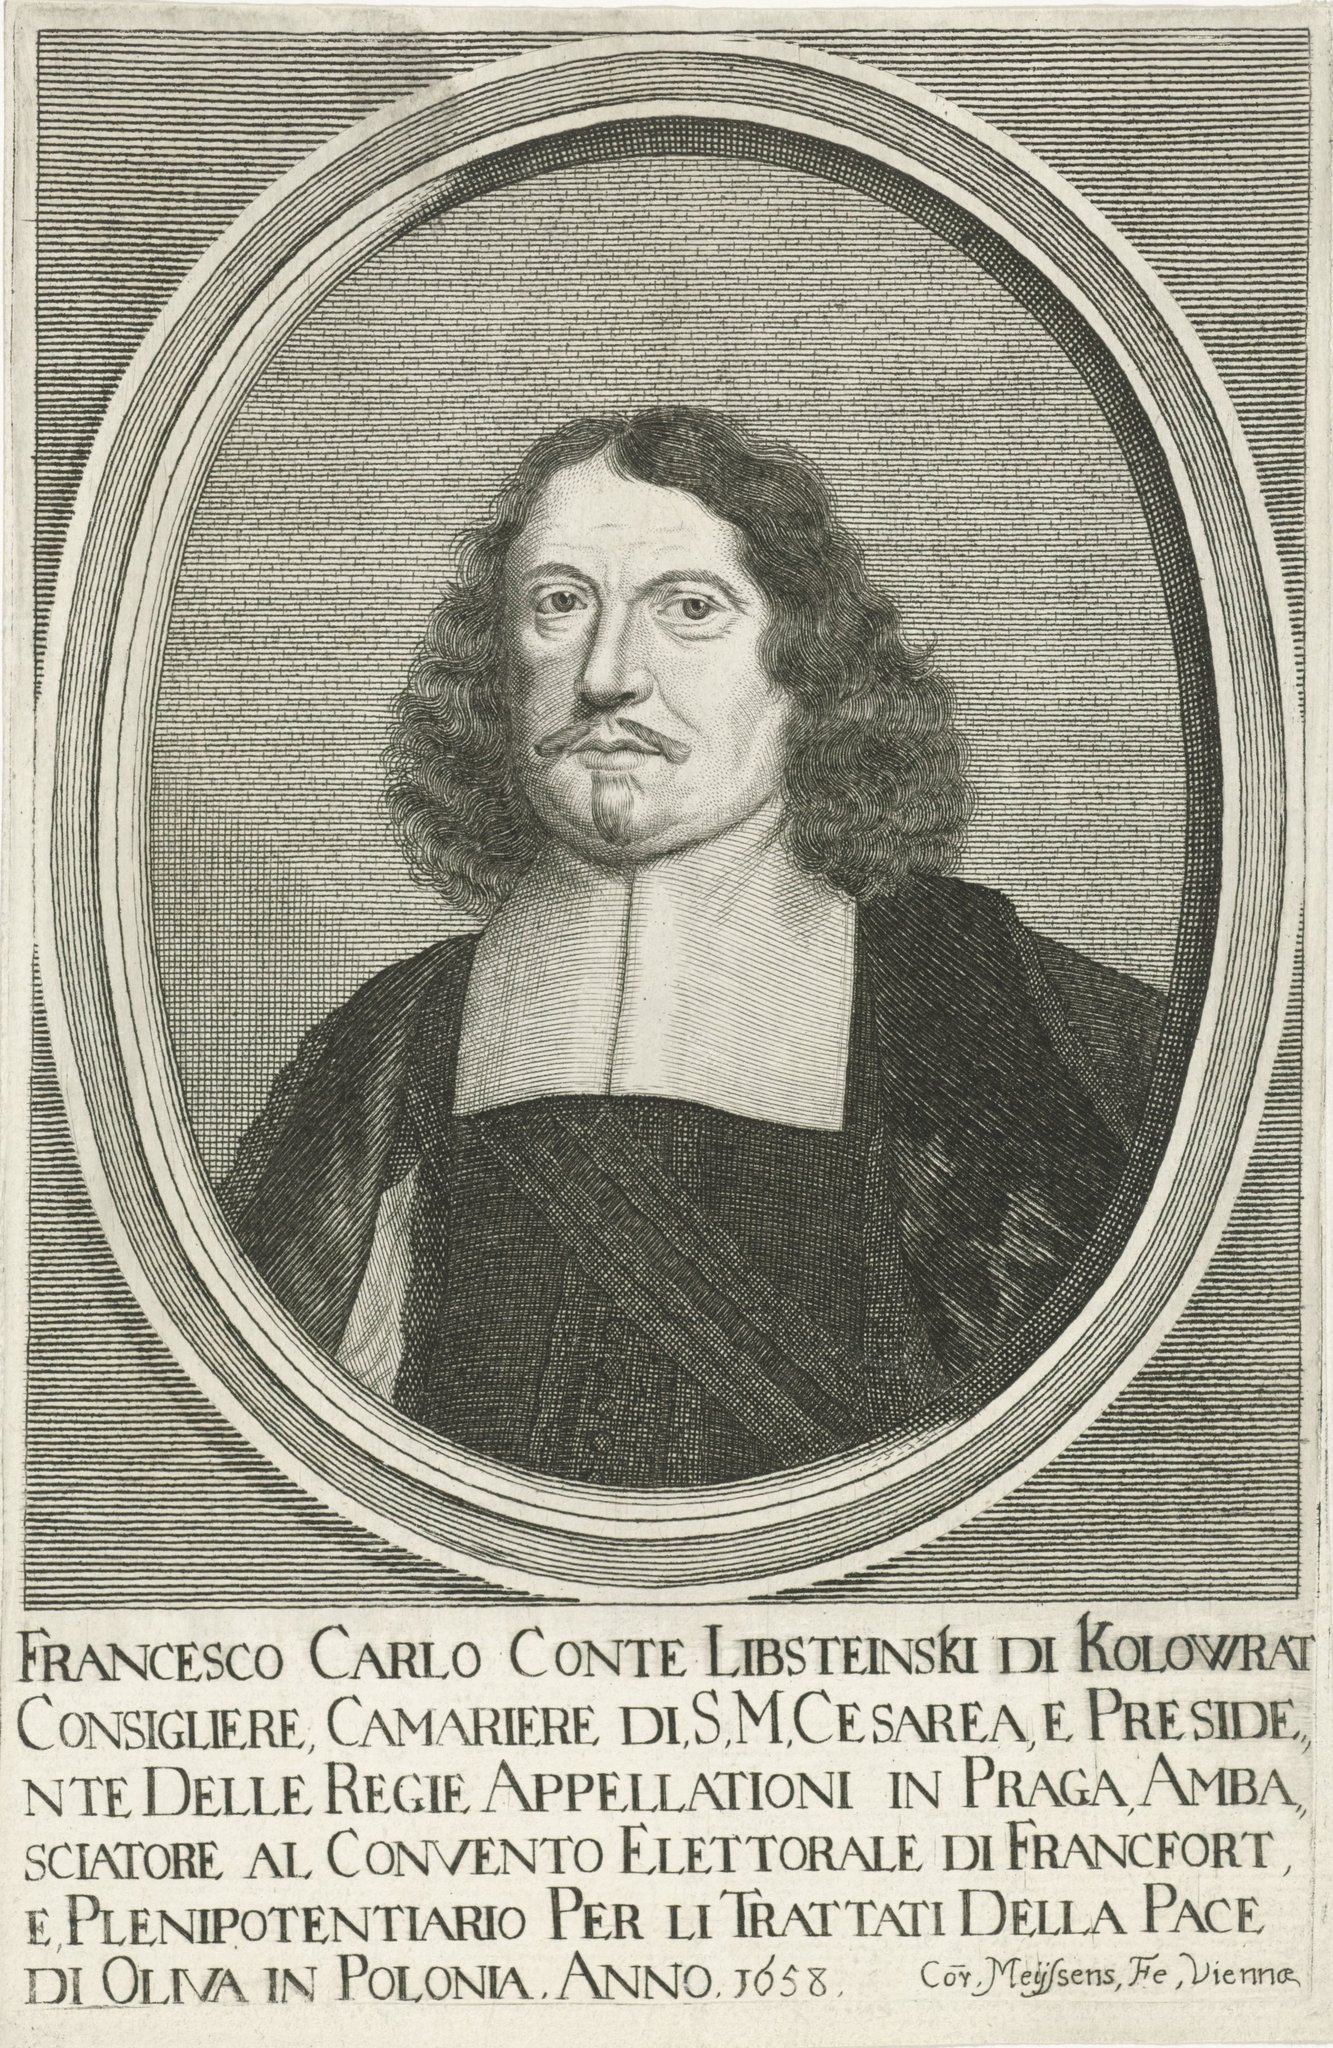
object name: book illustration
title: Portret van graaf Franz Karl van Kolowrat-Liebsteinsky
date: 1670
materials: paper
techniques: engraving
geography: vienna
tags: franz karl graaf van kolowrat-liebsteinsky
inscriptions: collector's mark: Lugt 2228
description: Portret van Franz Karl, graaf van Kolowrat-Liebsteinsky. Onderaan in de marge een vermelding van zijn titels en werkzaamheden in het Italiaans.